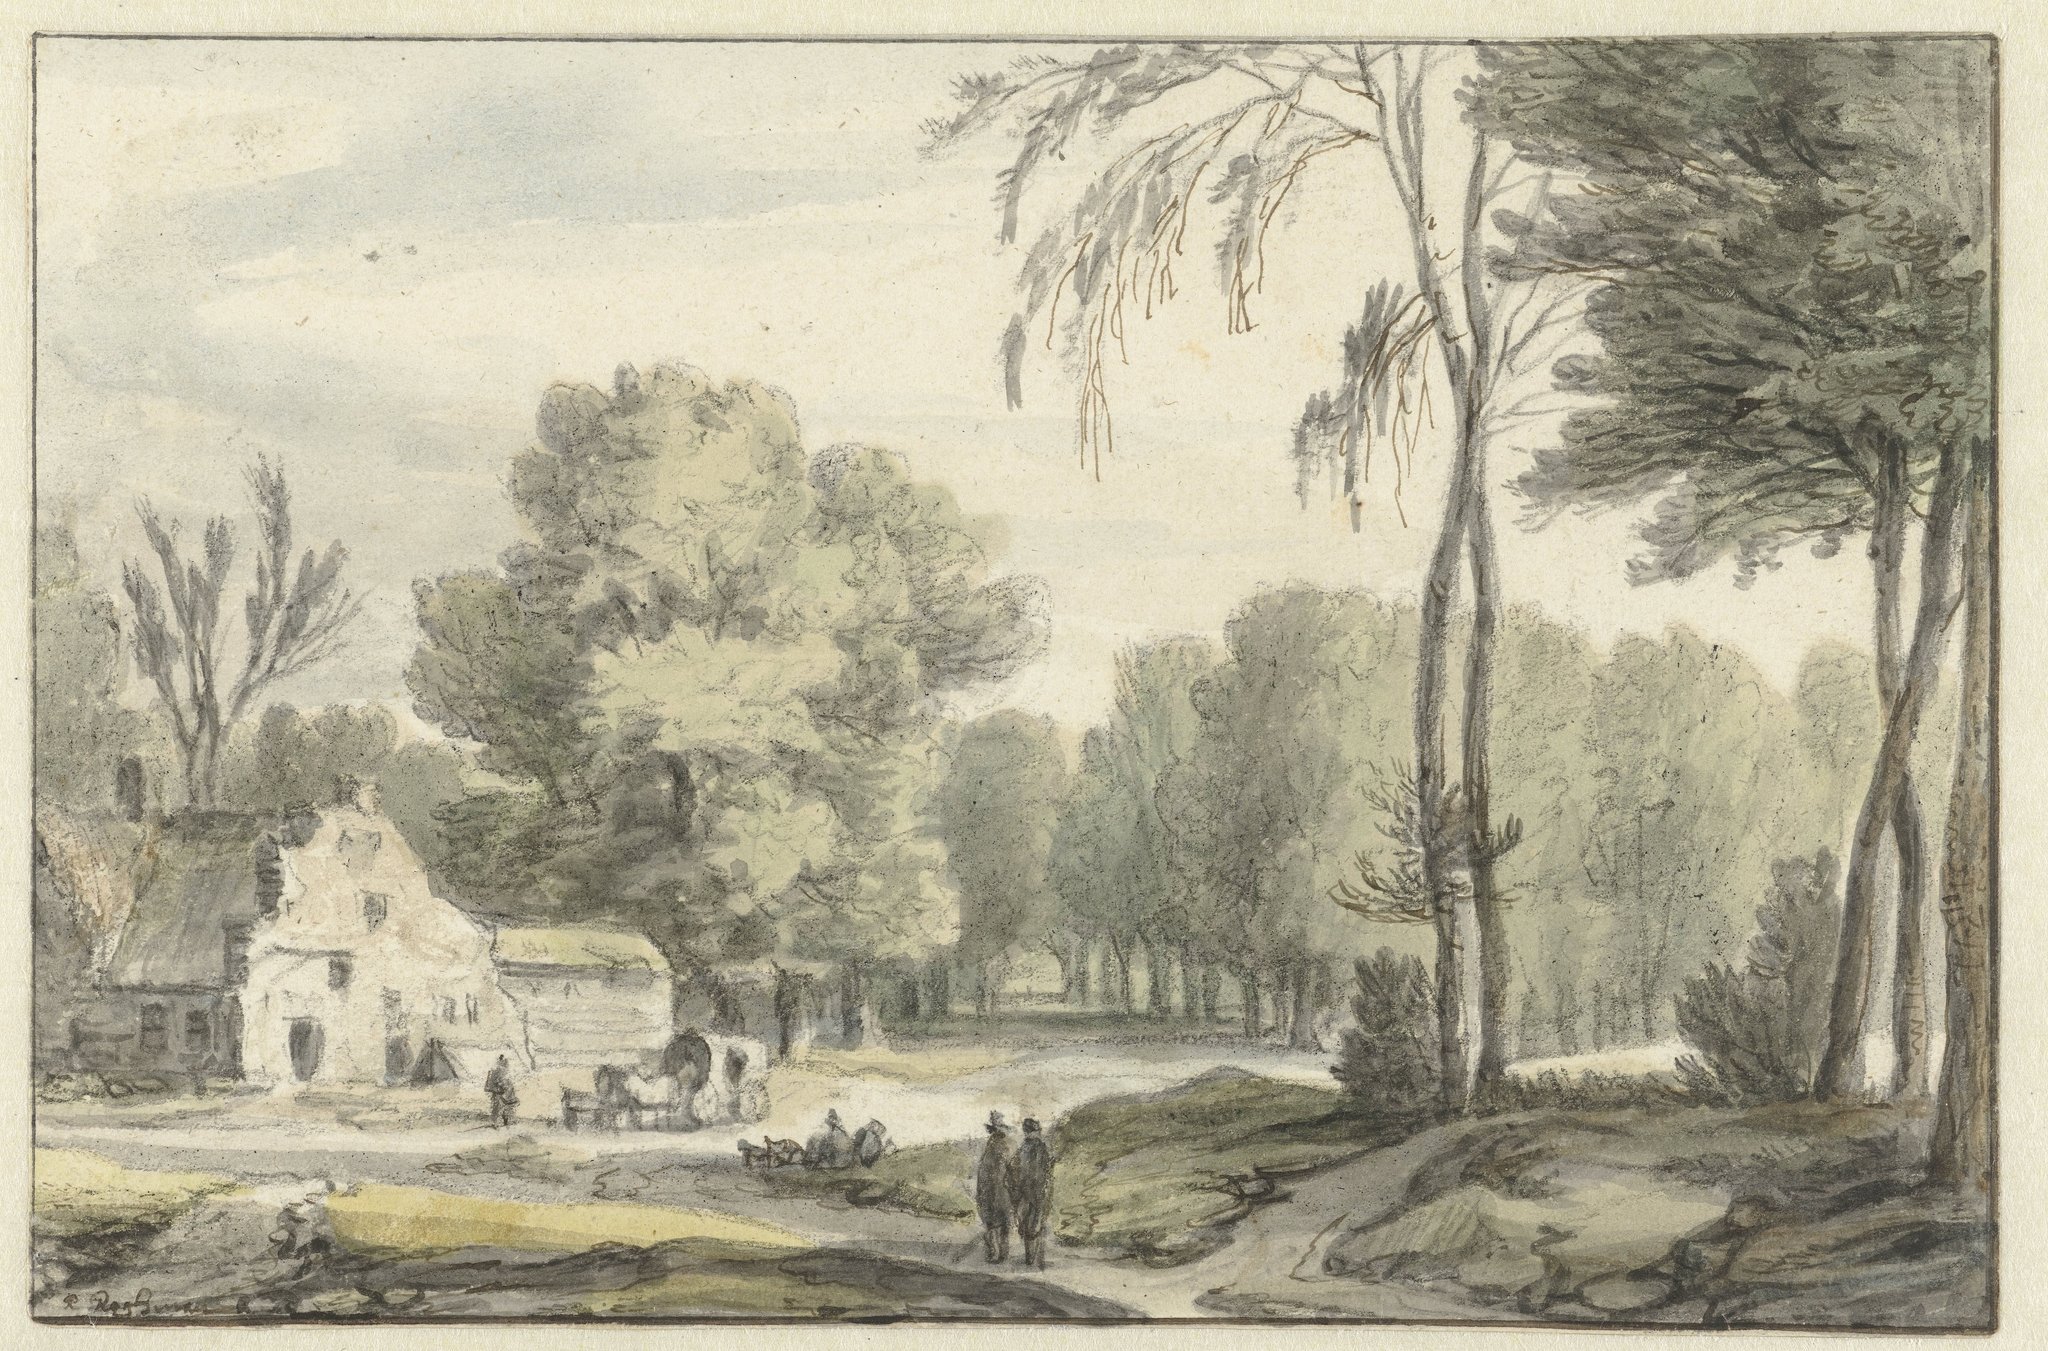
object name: drawing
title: Landschap met een reiswagen voor een boerderij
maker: roelant roghman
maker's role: draughtsman, painter, print maker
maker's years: 1627-1692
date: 1637-1692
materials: ink, paper, watercolor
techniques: brush, pen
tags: four-wheeled vehicle drawn by one animal, farm or solitary house in landscape, farm (building)